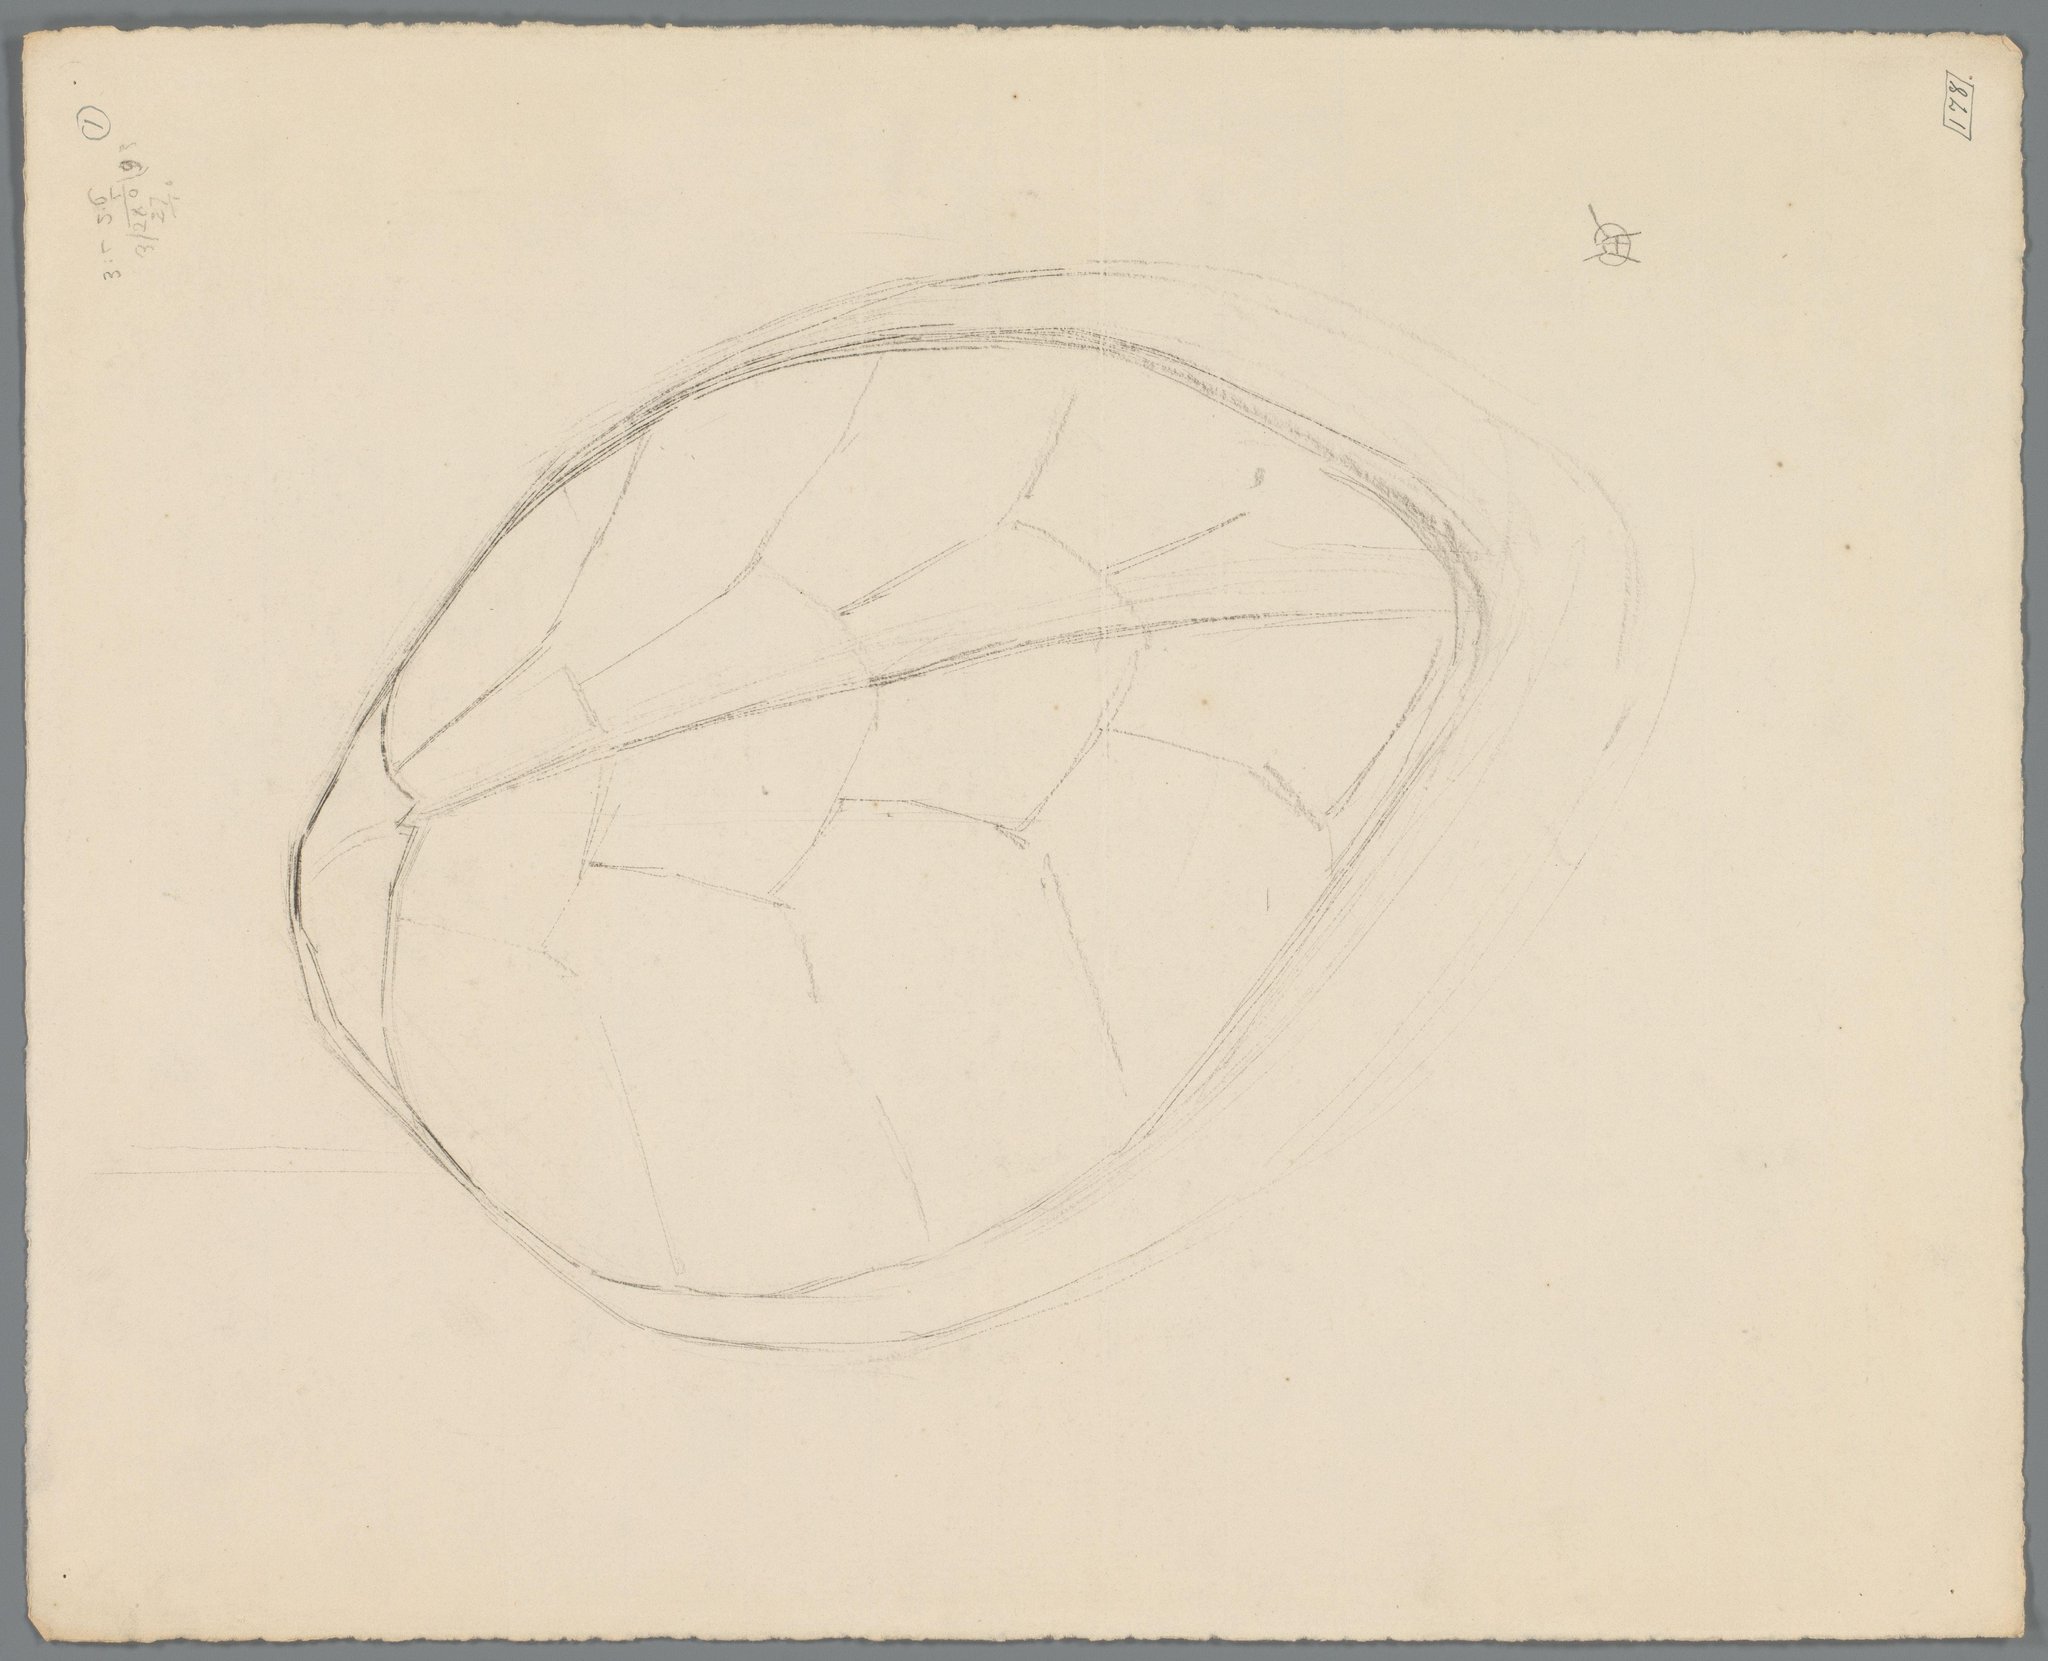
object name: drawing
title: Schild van een zeeschildpad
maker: gerrit willem dijsselhof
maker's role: designer, draughtsman, print maker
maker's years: 1866-1924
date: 1876-1924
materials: chalk, paper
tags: tortoises, turtles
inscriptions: number: ‘178’